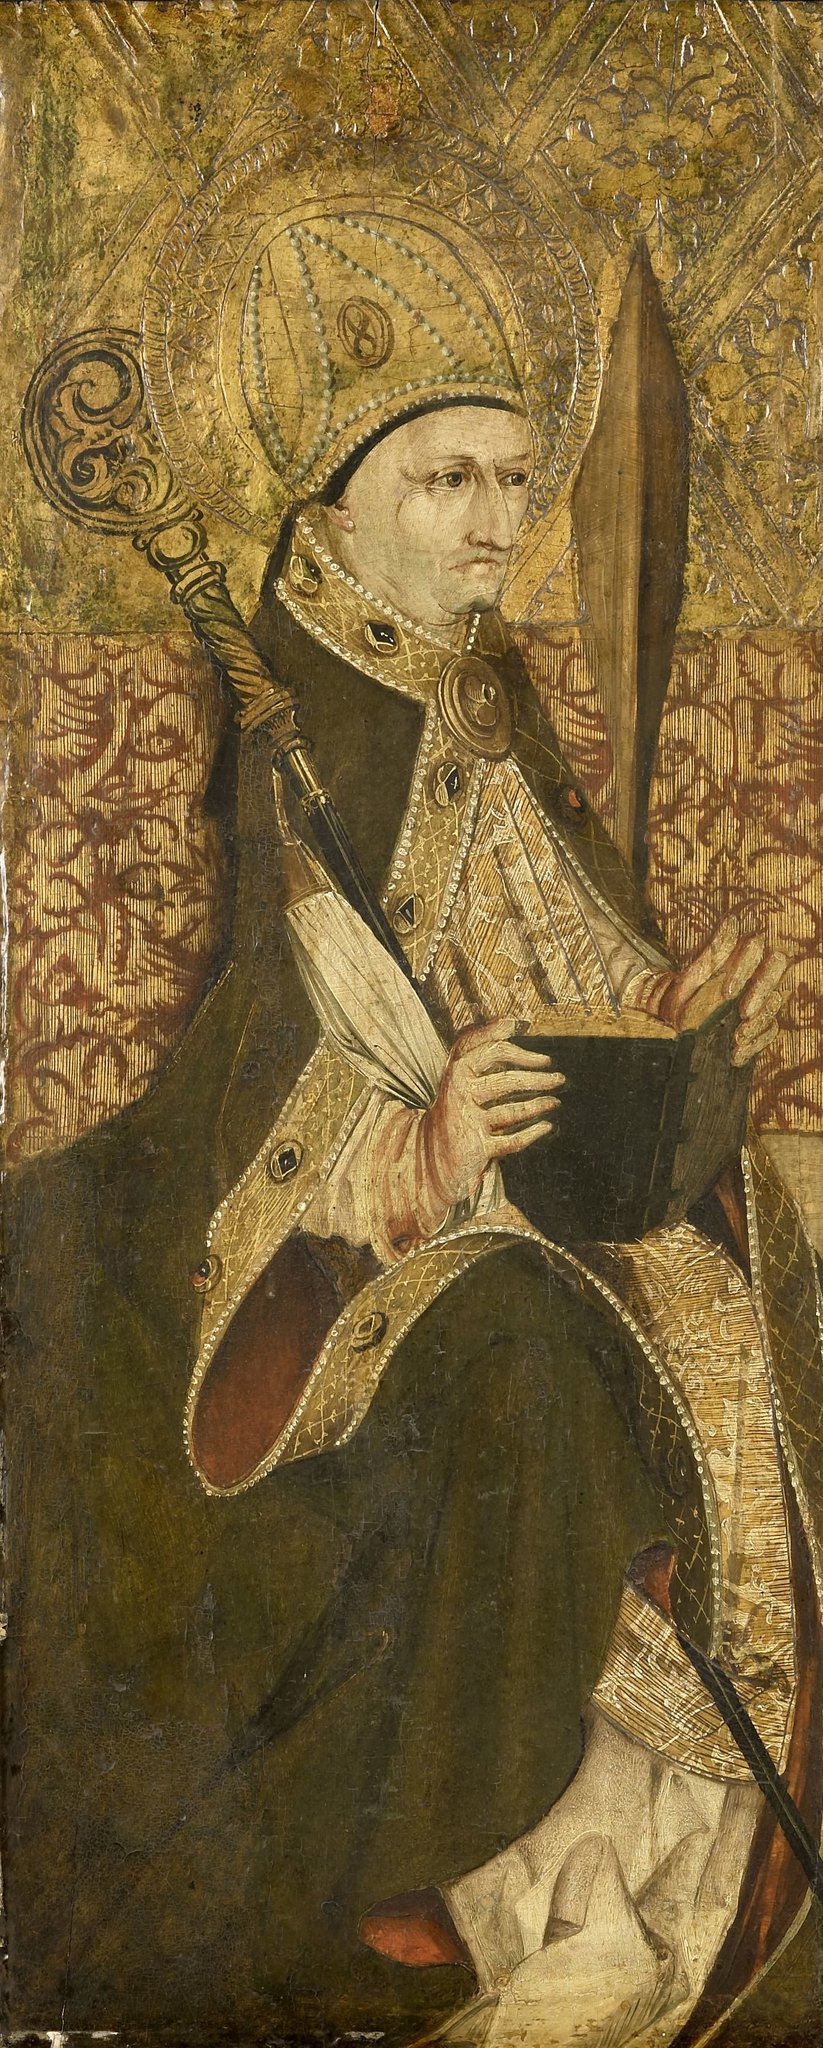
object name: painting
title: A Holy Bishop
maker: Anonymous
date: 1475-1499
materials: oil, panel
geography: spain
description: Een zittende heilige bisschop met een opengeslagen boek op schoot, achter hem een palmtak.